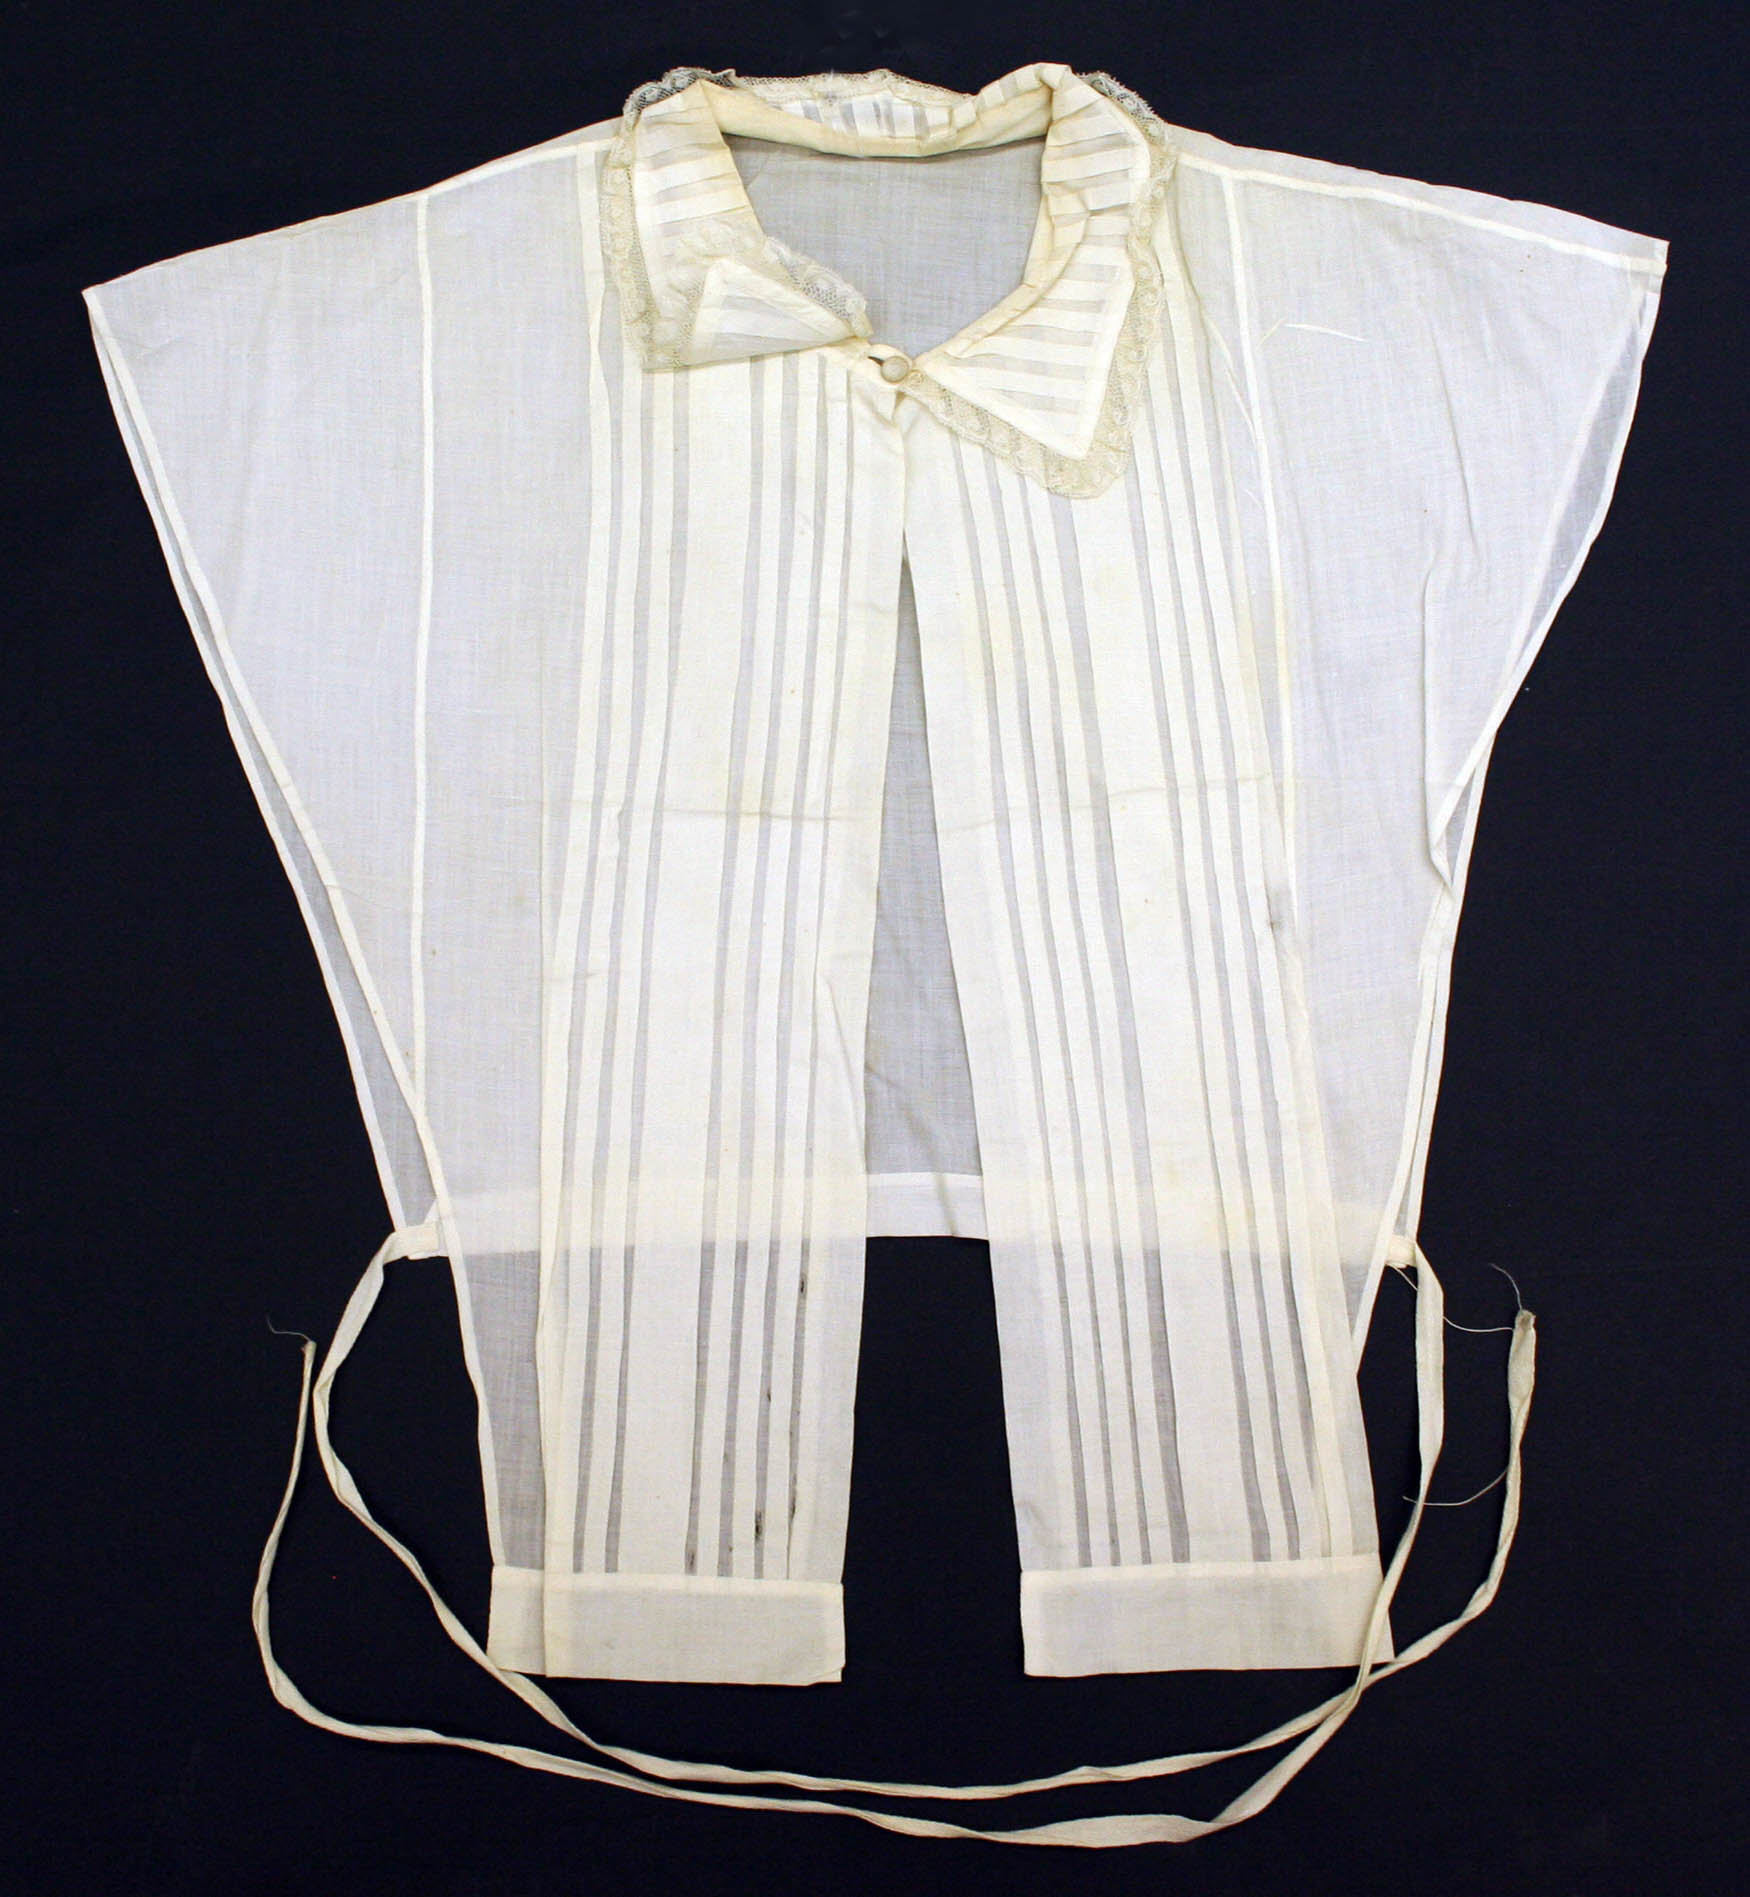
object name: accessory set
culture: american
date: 1850-1869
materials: cotton